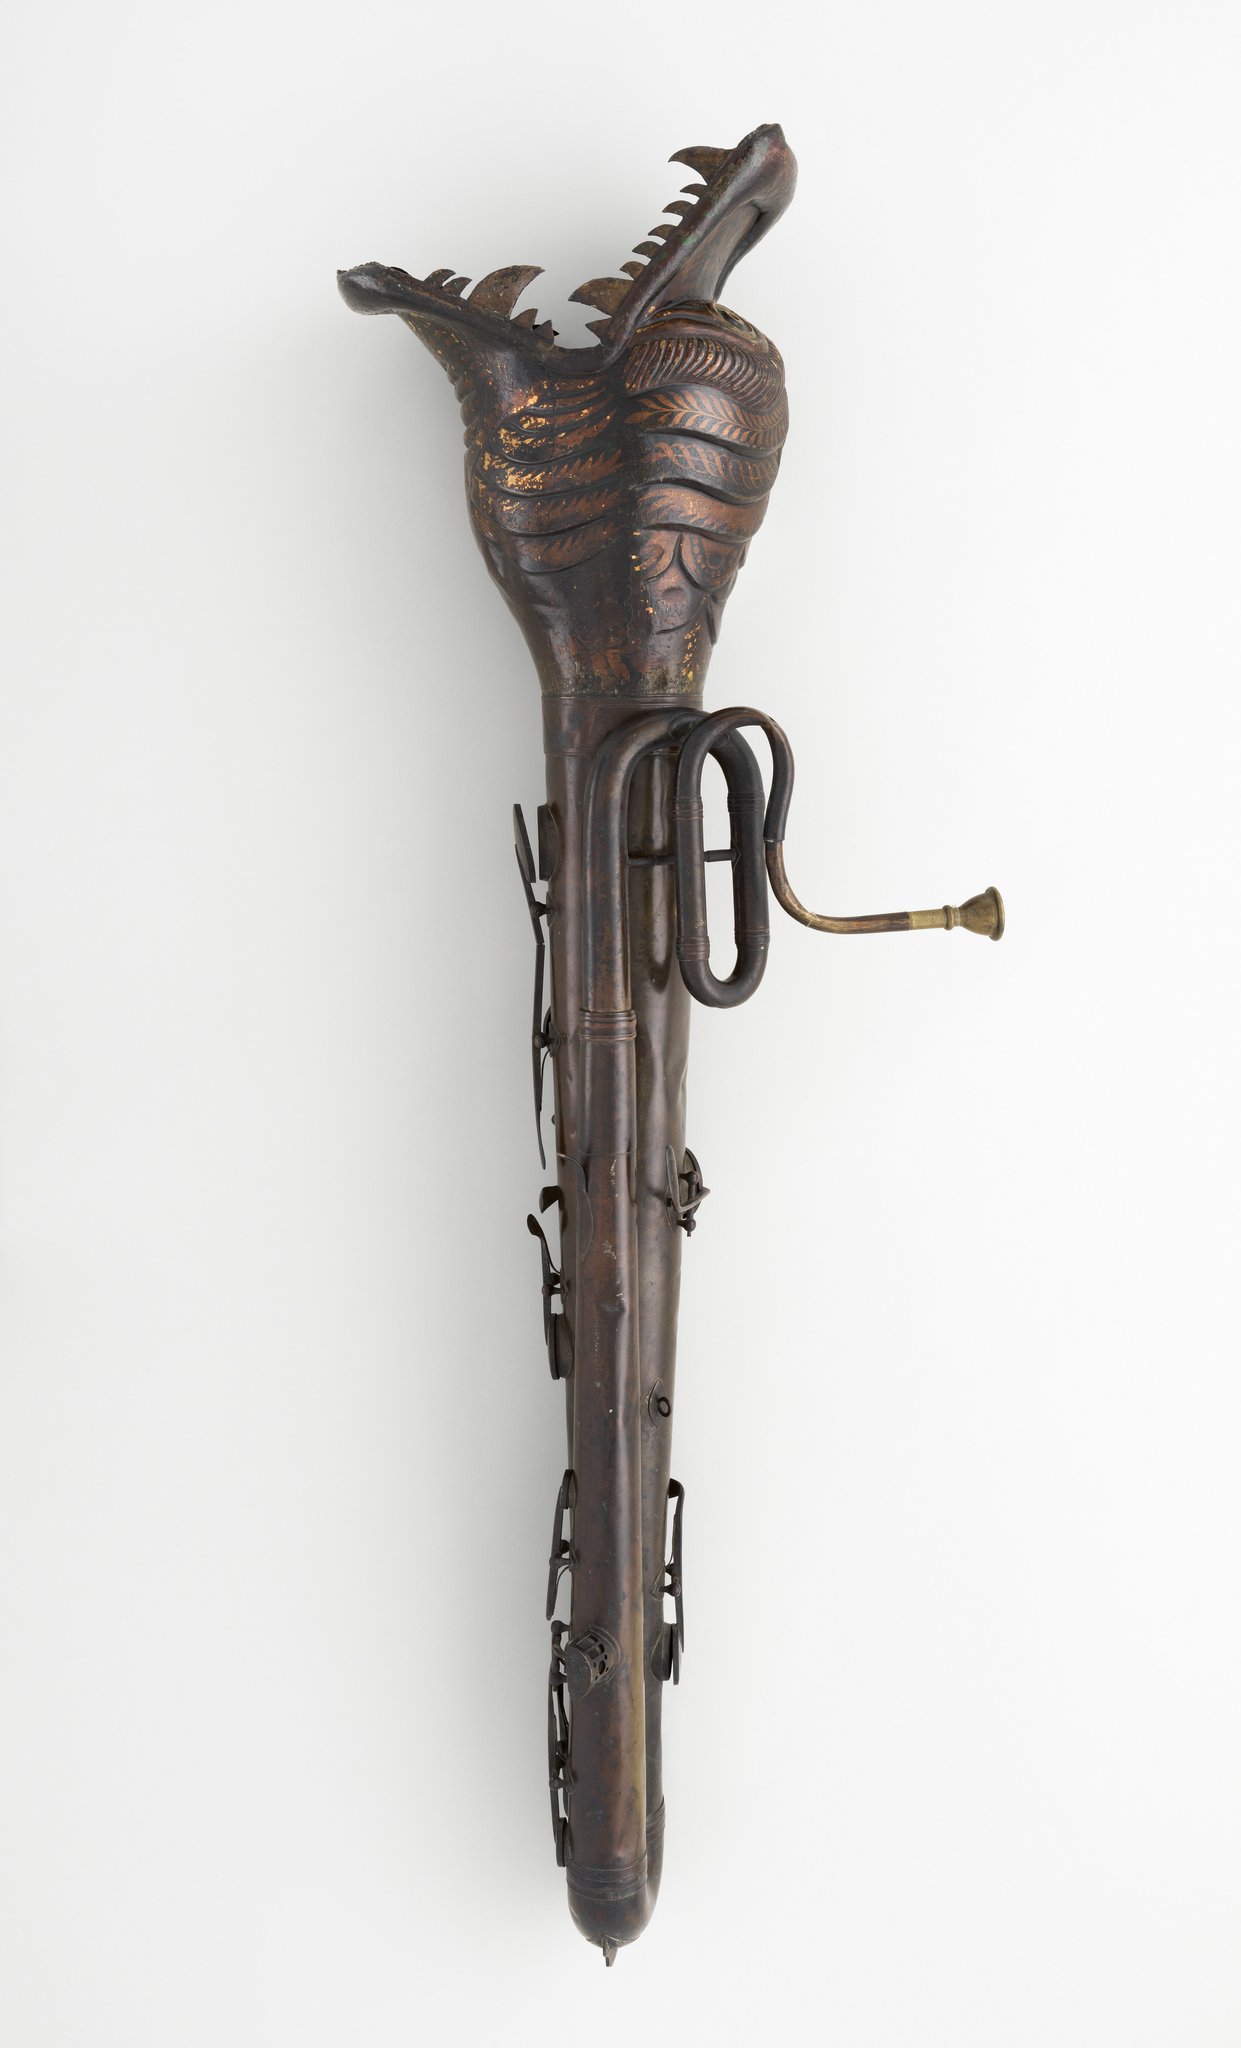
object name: bass ophicleide in b flat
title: Bass Ophicleide in B-flat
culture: european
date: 1825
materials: brass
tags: dragons